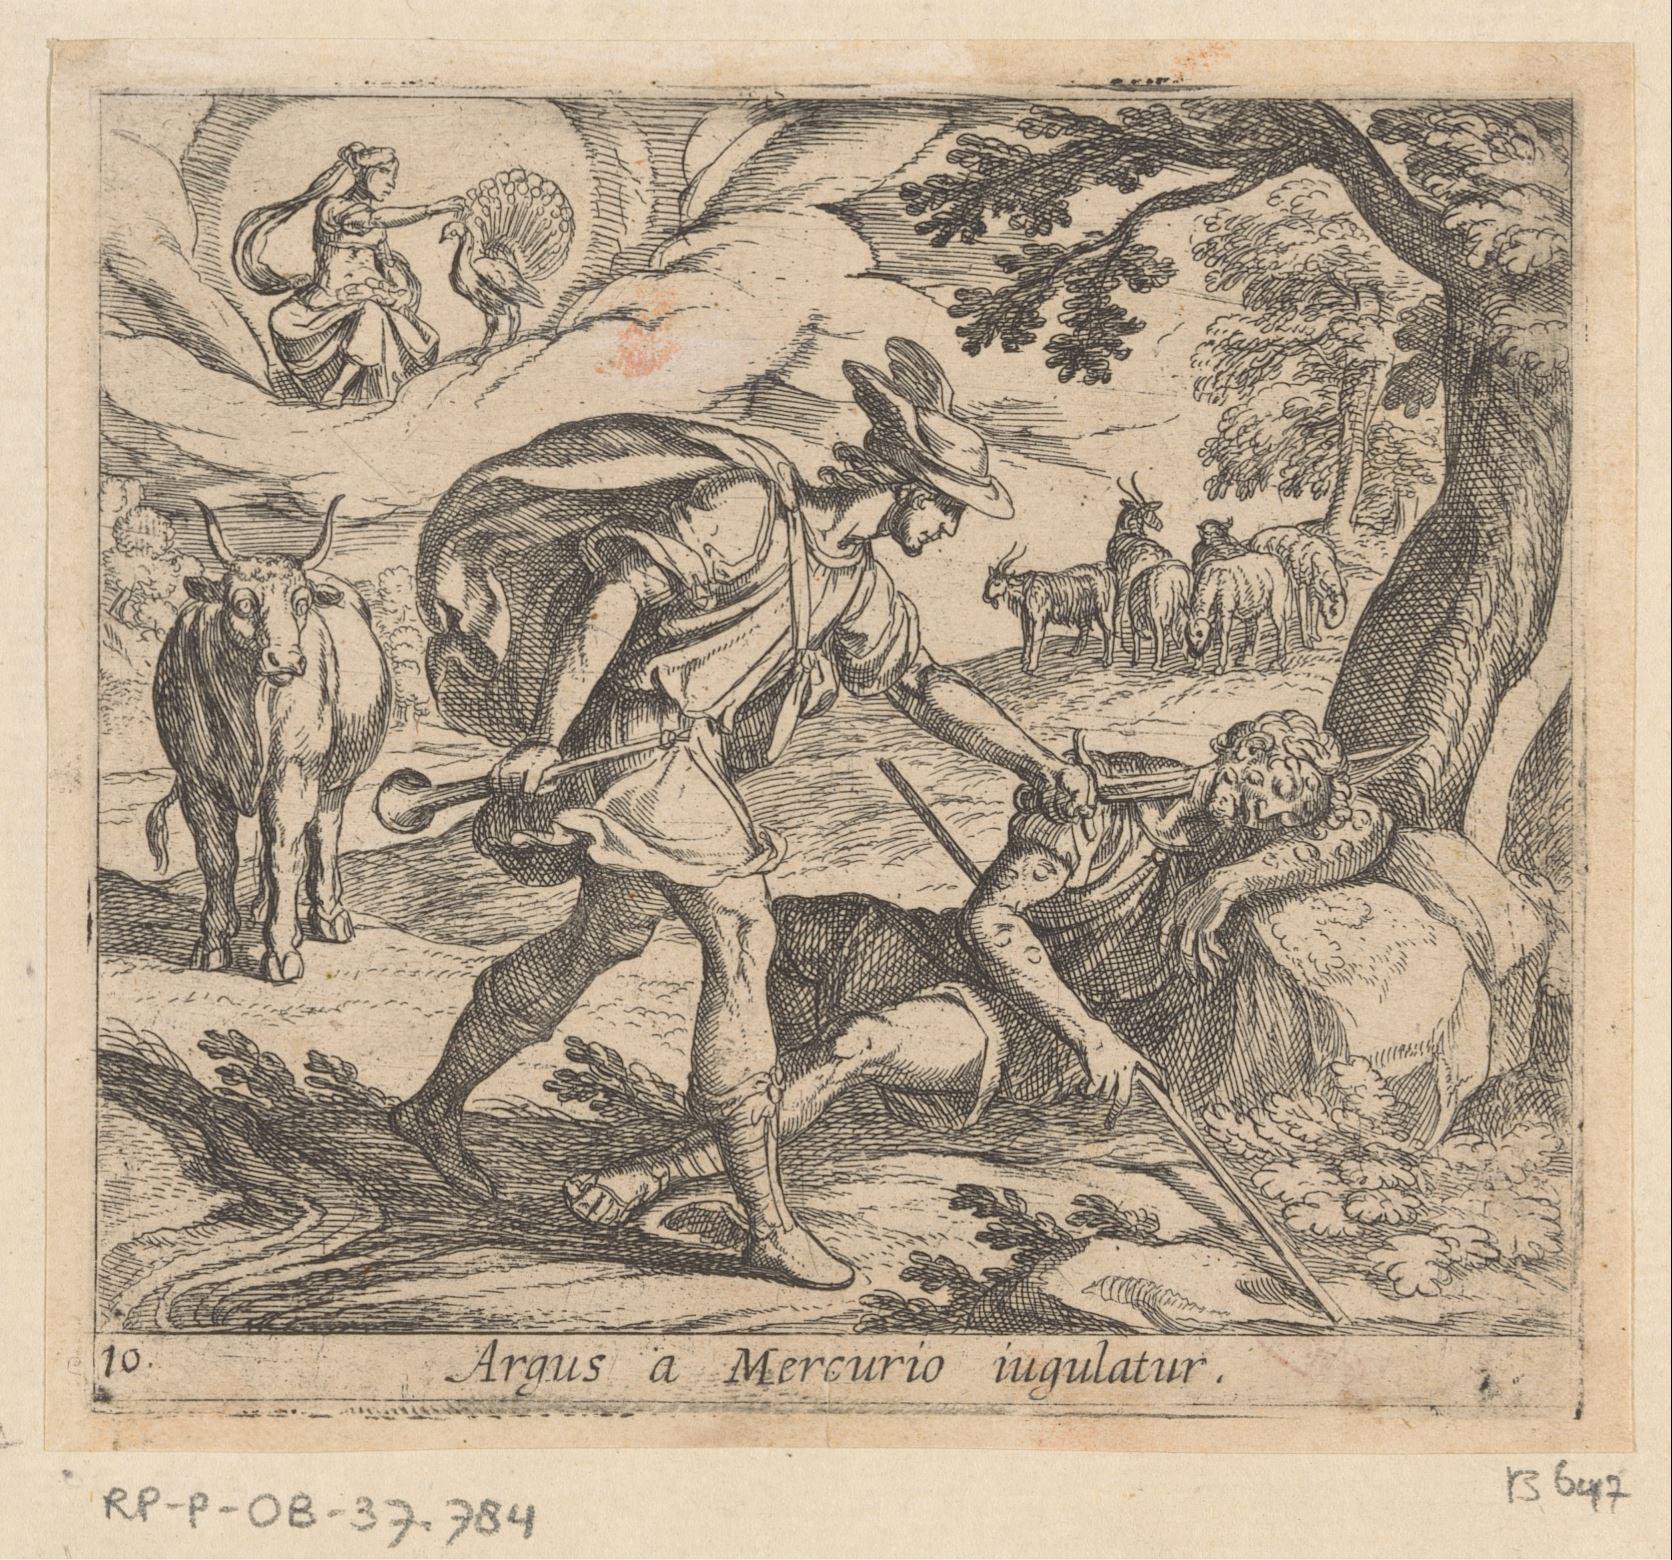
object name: print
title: Mercurius doodt Argus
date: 1606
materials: paper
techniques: etching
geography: italy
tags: (story of) mercury (hermes), mercury beheads argus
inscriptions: collector's mark: Lugt 240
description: Mercurius snijdt met zijn zwaard het hoofd van de slapende Argus af. Juno zit met een pauw op wolken. In het landschap staan een os en een kudde bokken en schapen. Titel in het Latijn in ondermarge.